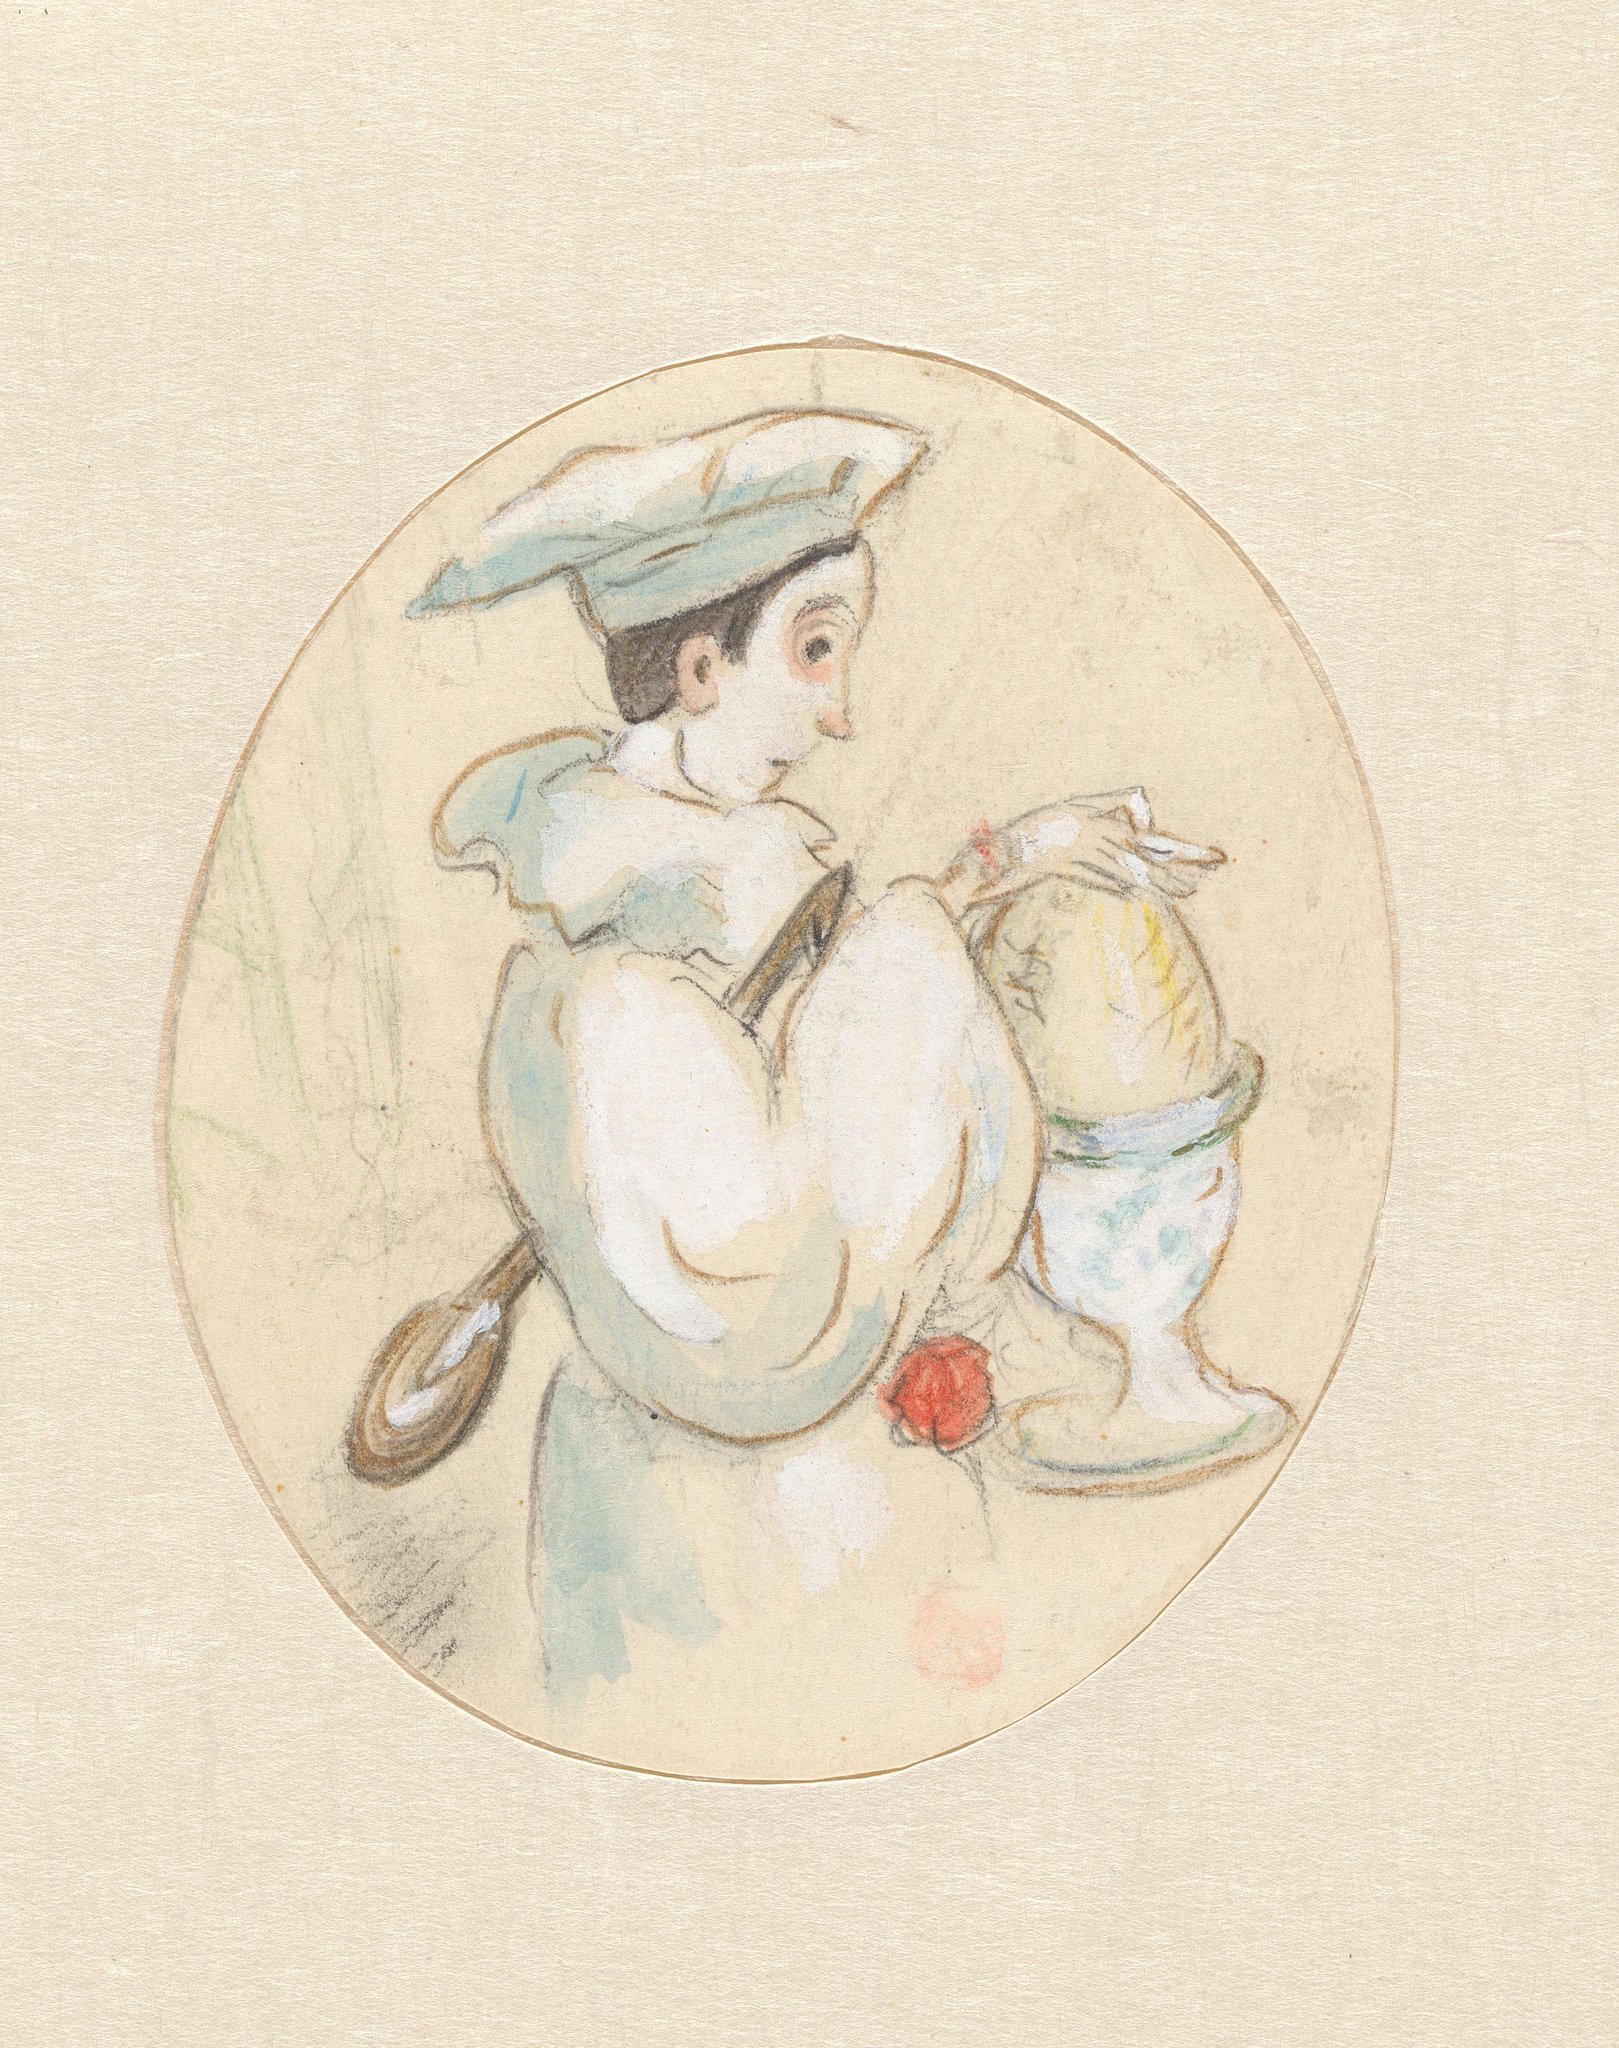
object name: drawing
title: Pierrot en het reuzenei van Vogel Rok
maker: nelly bodenheim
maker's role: designer, draughtsman, print maker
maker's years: 1874-1951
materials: paint, paper, pencil, watercolor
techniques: brush